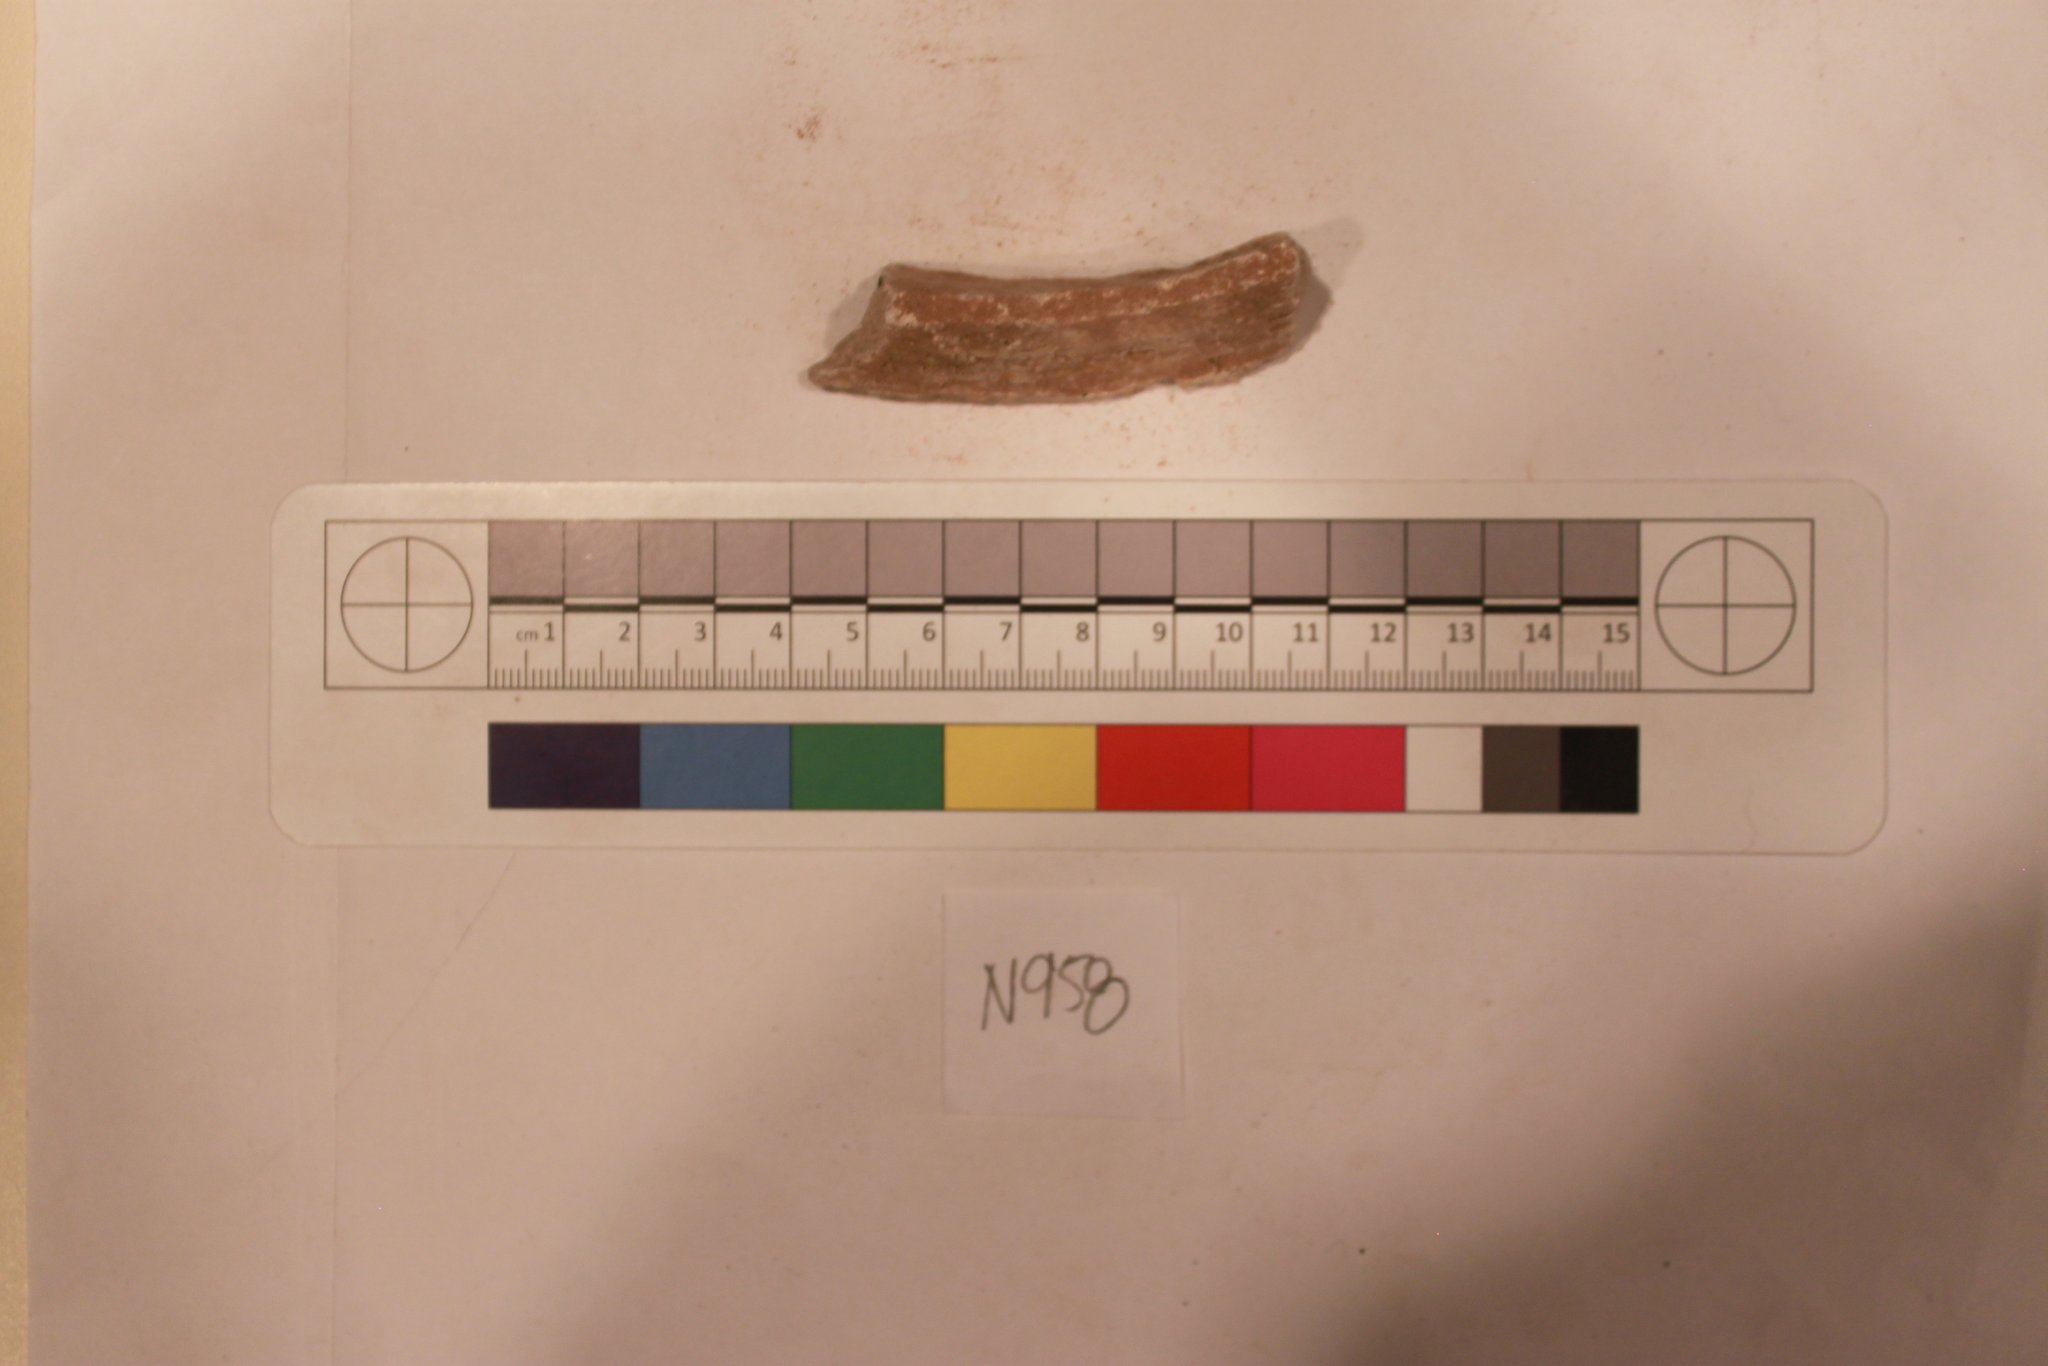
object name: fragment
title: Stucco Fragment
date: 701-1200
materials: plaster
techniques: carving, painting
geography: iran